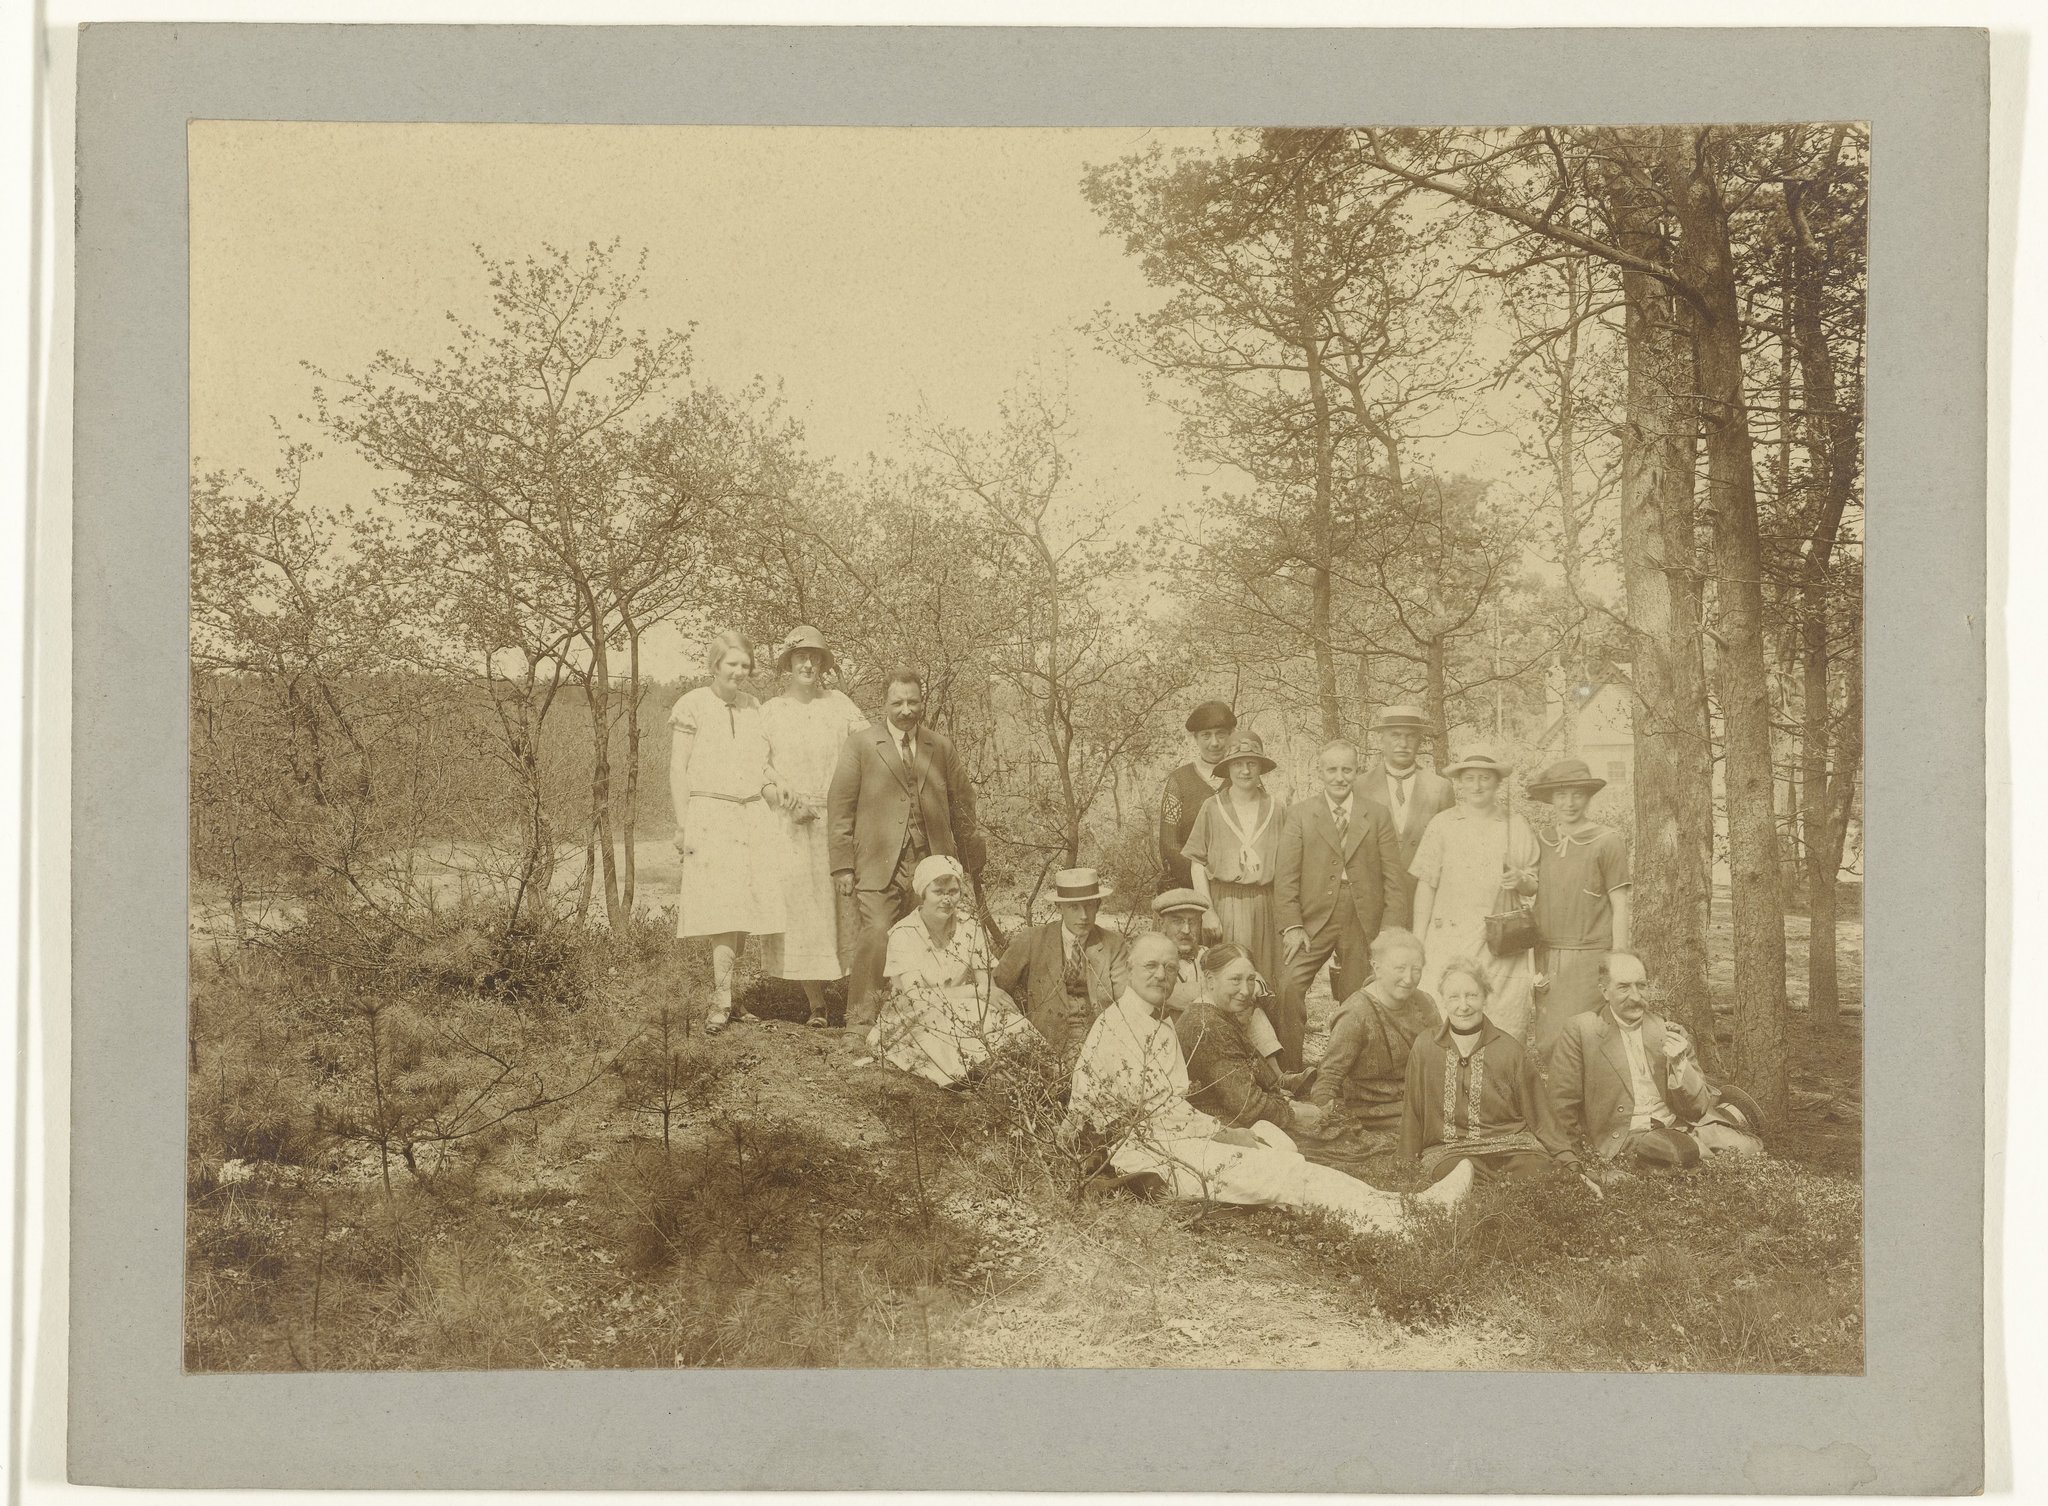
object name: photograph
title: Groepsportret van zeventien mannen en vrouwen in een bos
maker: richard tepe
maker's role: fotograaf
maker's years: 1864-1952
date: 1900-1930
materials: paper, cardboard, photographic support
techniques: gelatin silver print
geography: netherlands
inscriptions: signature: ‘foto / R. Tepe’